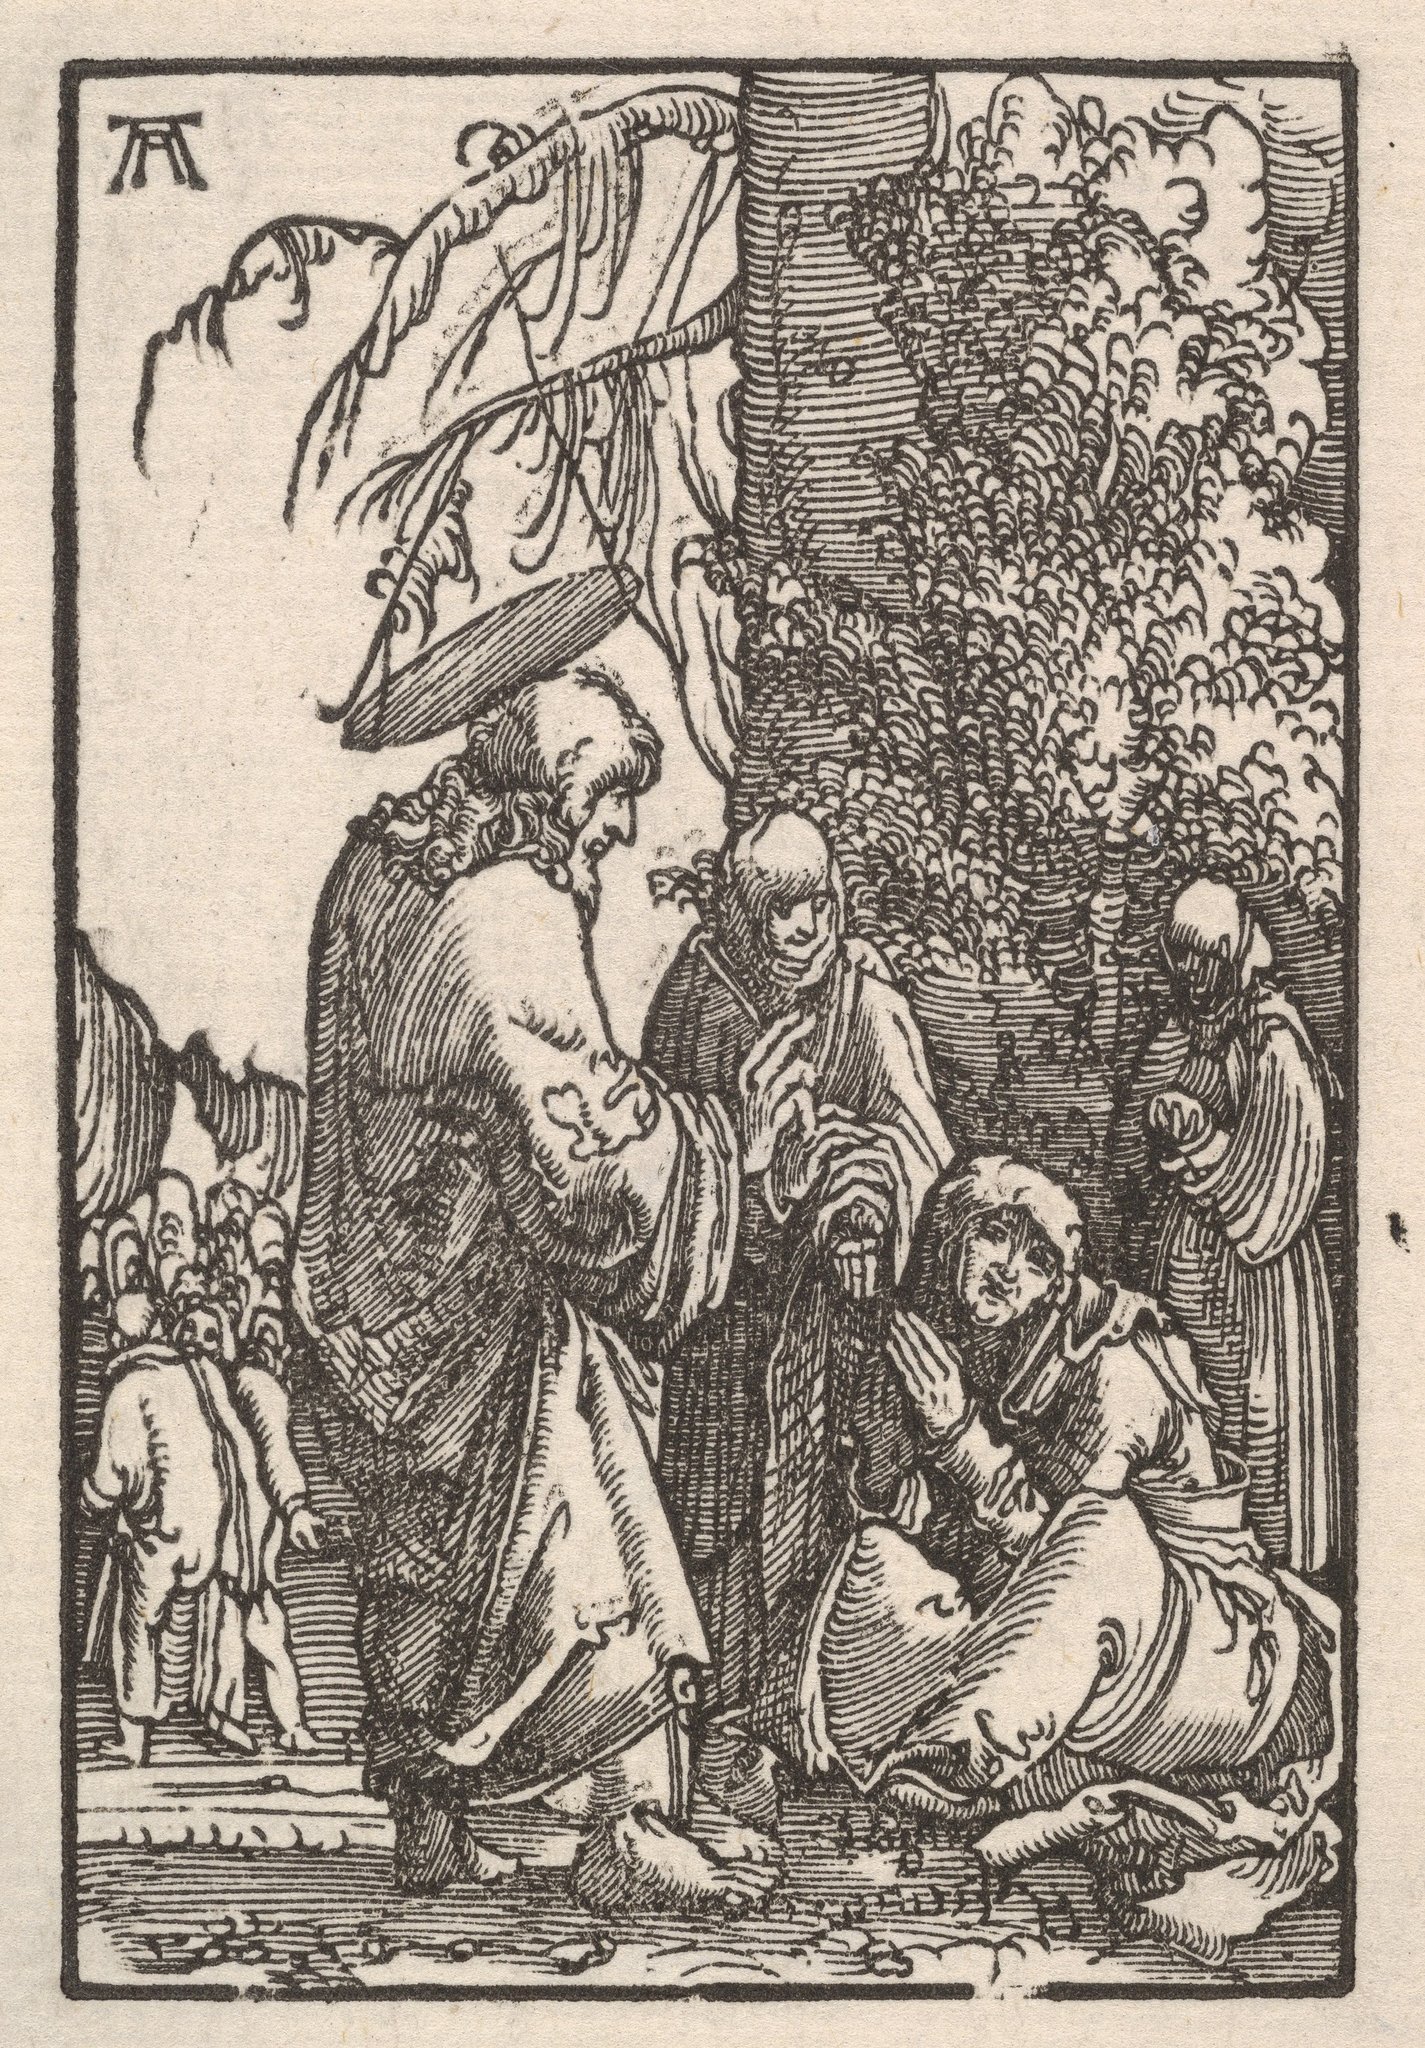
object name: print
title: Christ Taking Leave of His Mother, from "The Fall and Salvation of Mankind Through the Life and Passion of Christ"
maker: albrecht altdorfer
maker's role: artist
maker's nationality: german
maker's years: 1480-1538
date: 1513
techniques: woodcut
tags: men,women,christ,virgin mary